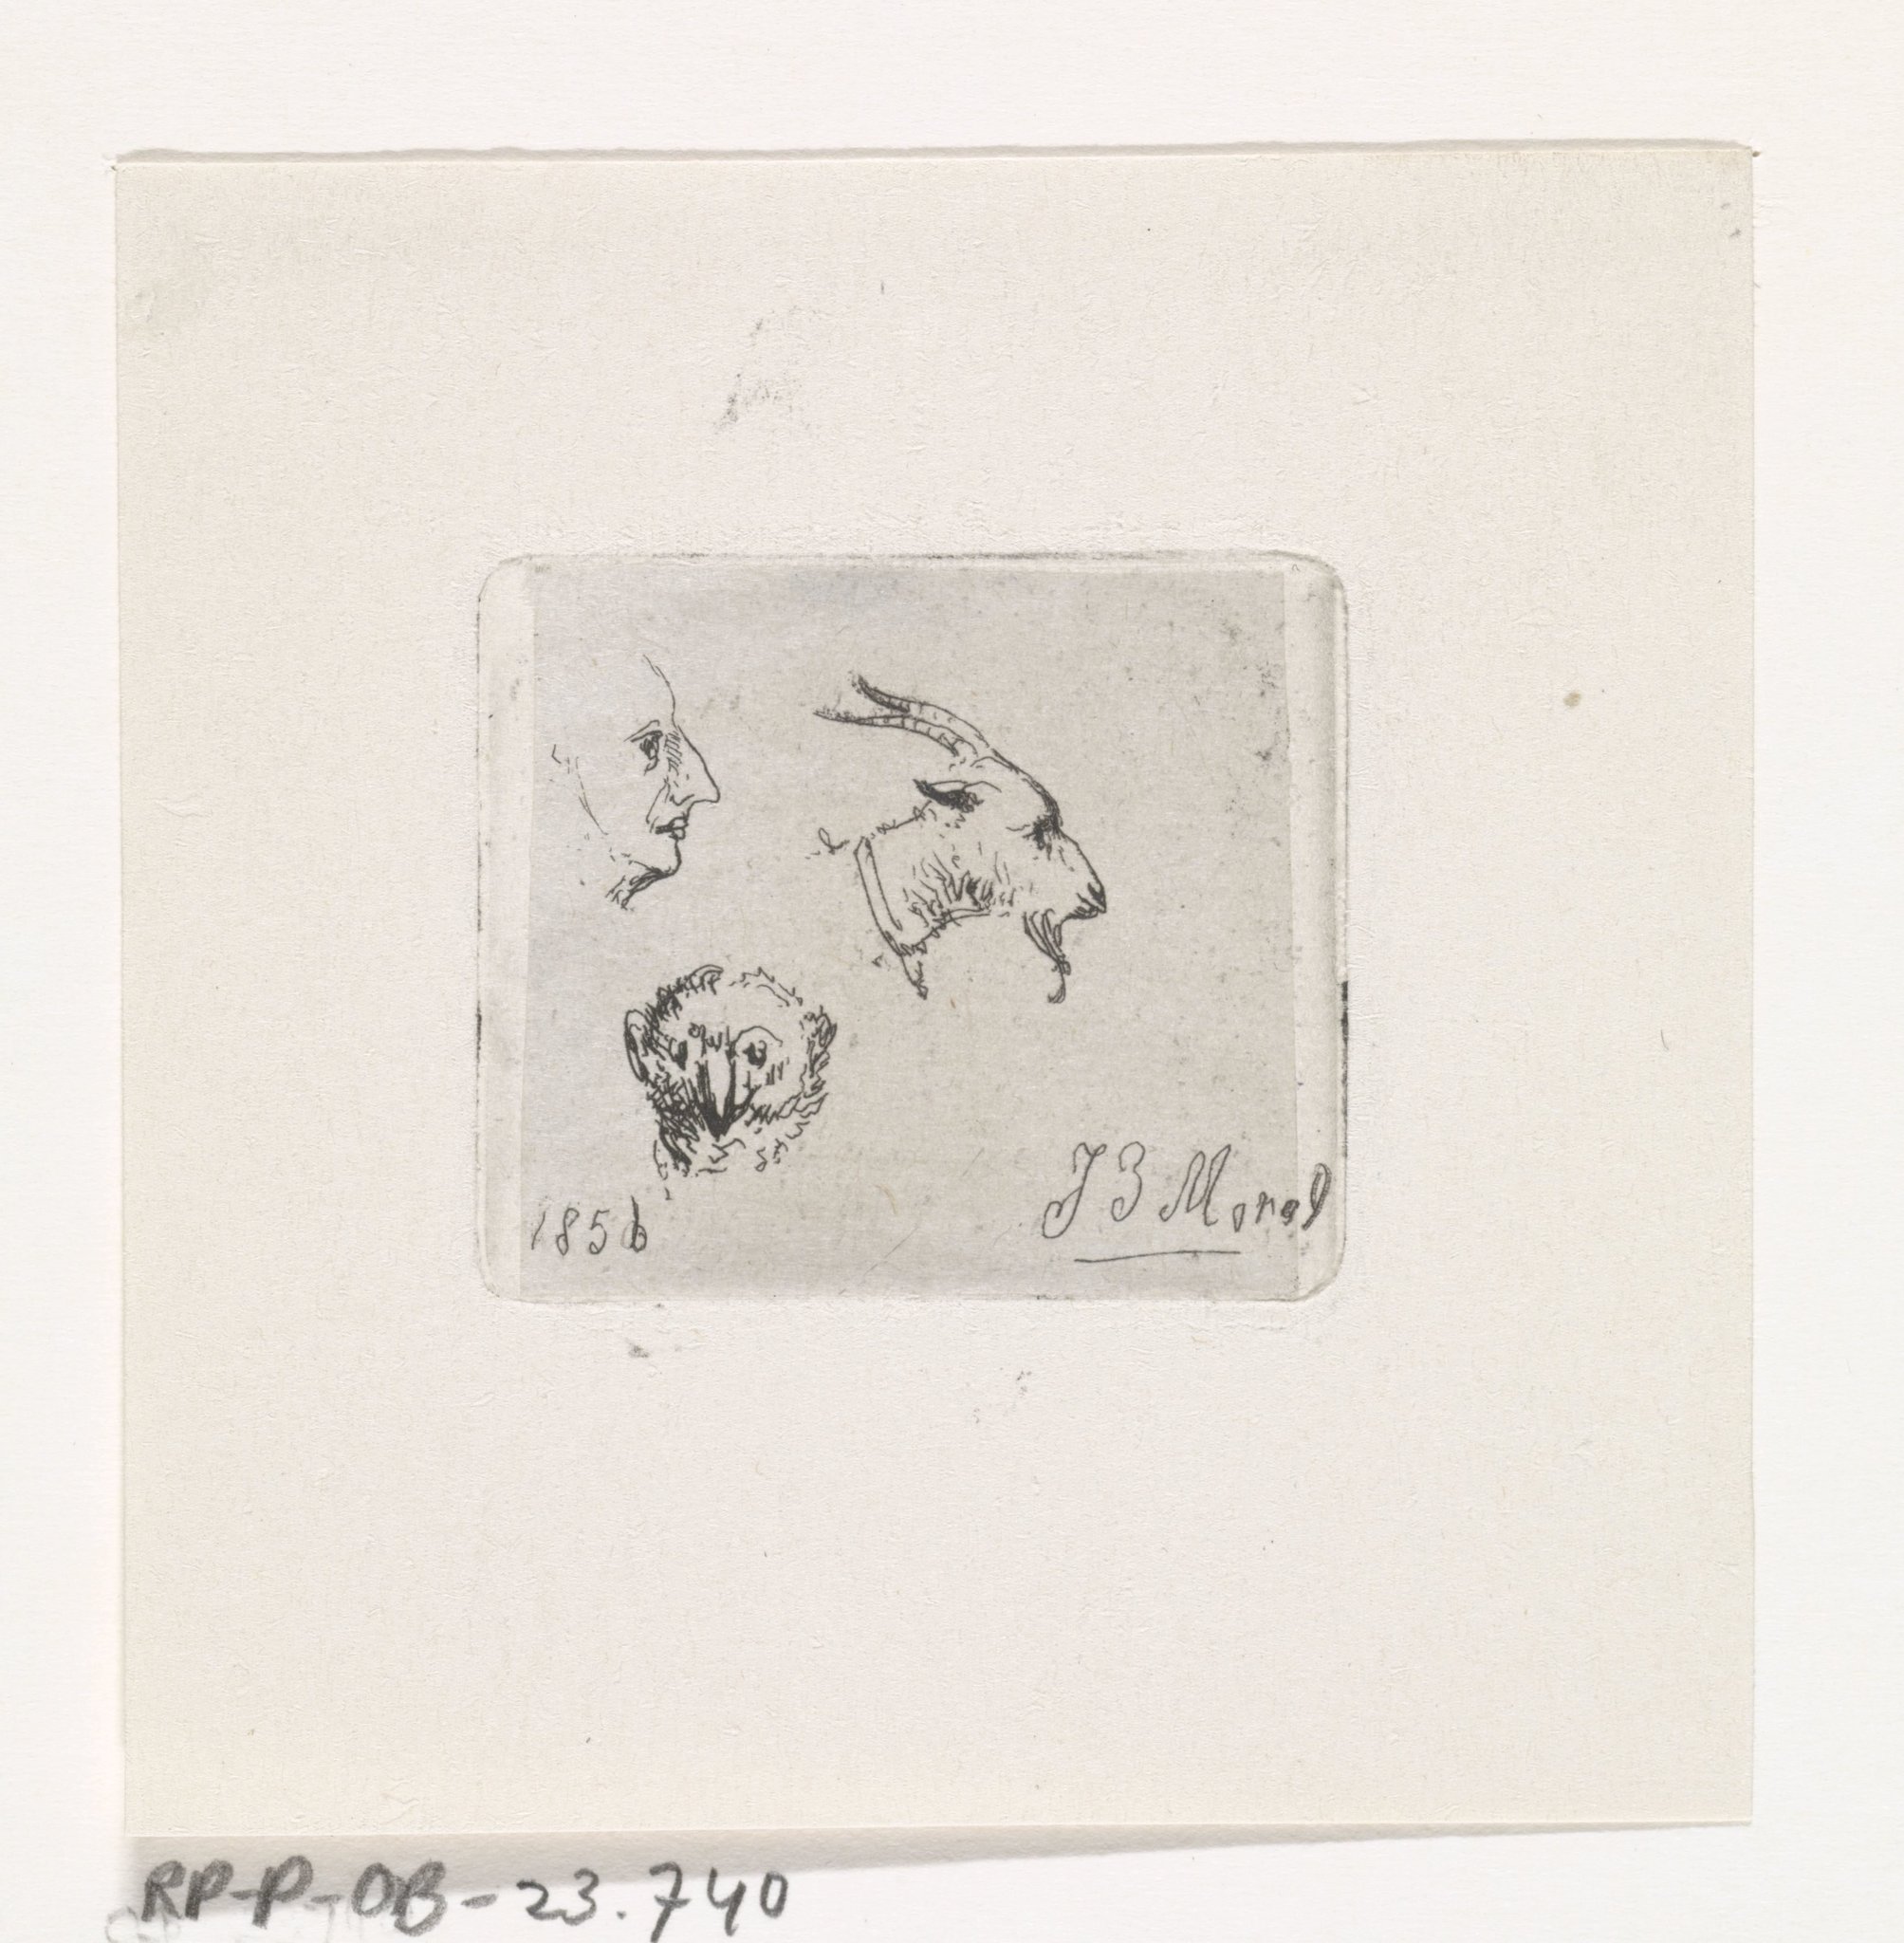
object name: print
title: Manshoofd, geit en uil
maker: jan evert morel (ii)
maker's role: painter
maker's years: 1835-1905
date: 1856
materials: paper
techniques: etching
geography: the hague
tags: adult man, owls, goat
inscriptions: collector's mark: Lugt 2228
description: Een manshoofd en een geitenkop en profil. Onderaan de kop van een uil van voren.